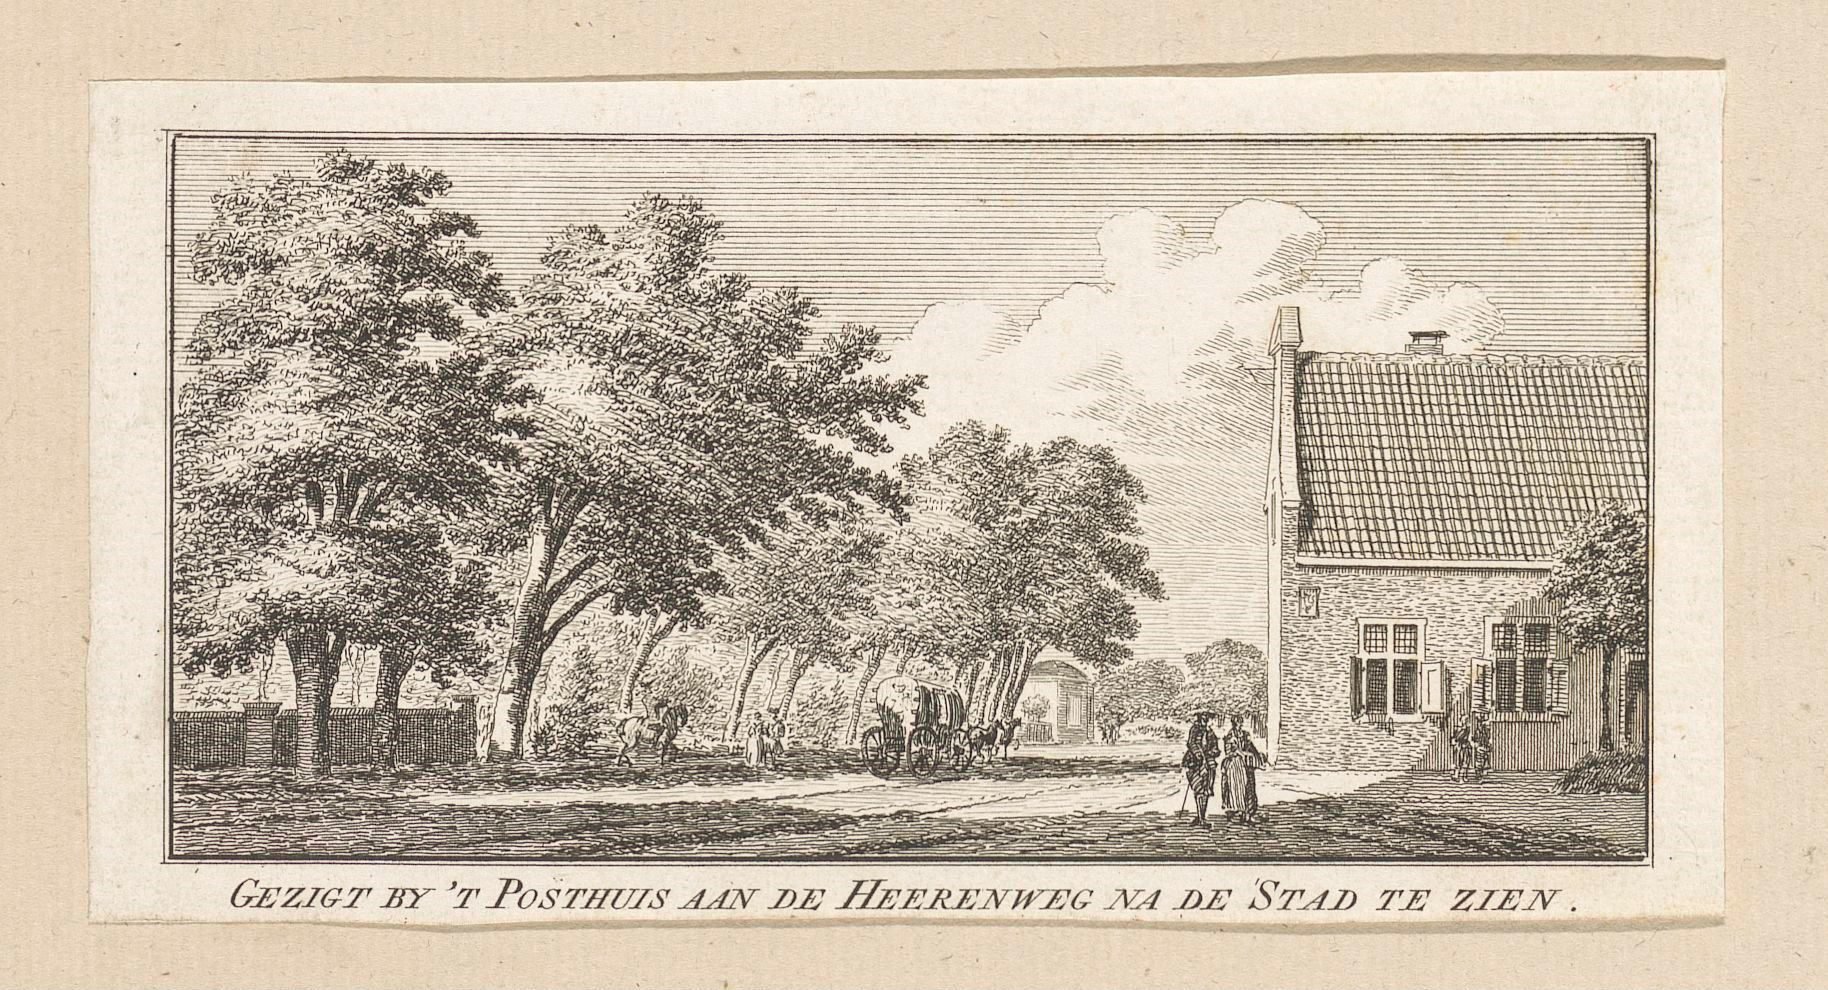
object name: print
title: Gezigt van de Leidse Vaart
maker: cornelis van noorde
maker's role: draughtsman, print maker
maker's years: 1731-1795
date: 1762-1763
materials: paper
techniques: etching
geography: haarlem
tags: canal, bridge, haarlem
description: Deze prent is afgesneden van een prent met daarop drie voorstellingen. In zijn geheel is deze prent ook gebruikt in: Vervolg der aangenaame gezichten van Haarlem. Haarlem: Jan Bosch, 1762. En in: Verzaameling van zes-en zestig aangenaame gezichten in de vermakelyke landsdouwen van Haarlem, nieuwlings naar 't leeven getekend door de beroemde konstenaars H. Spilman en C.V. Noorde, nevens eene afbeelding van het laatst angelegde bosch in het Haarlemsche Hout. Haarlem: Jan Bosch, 1763.